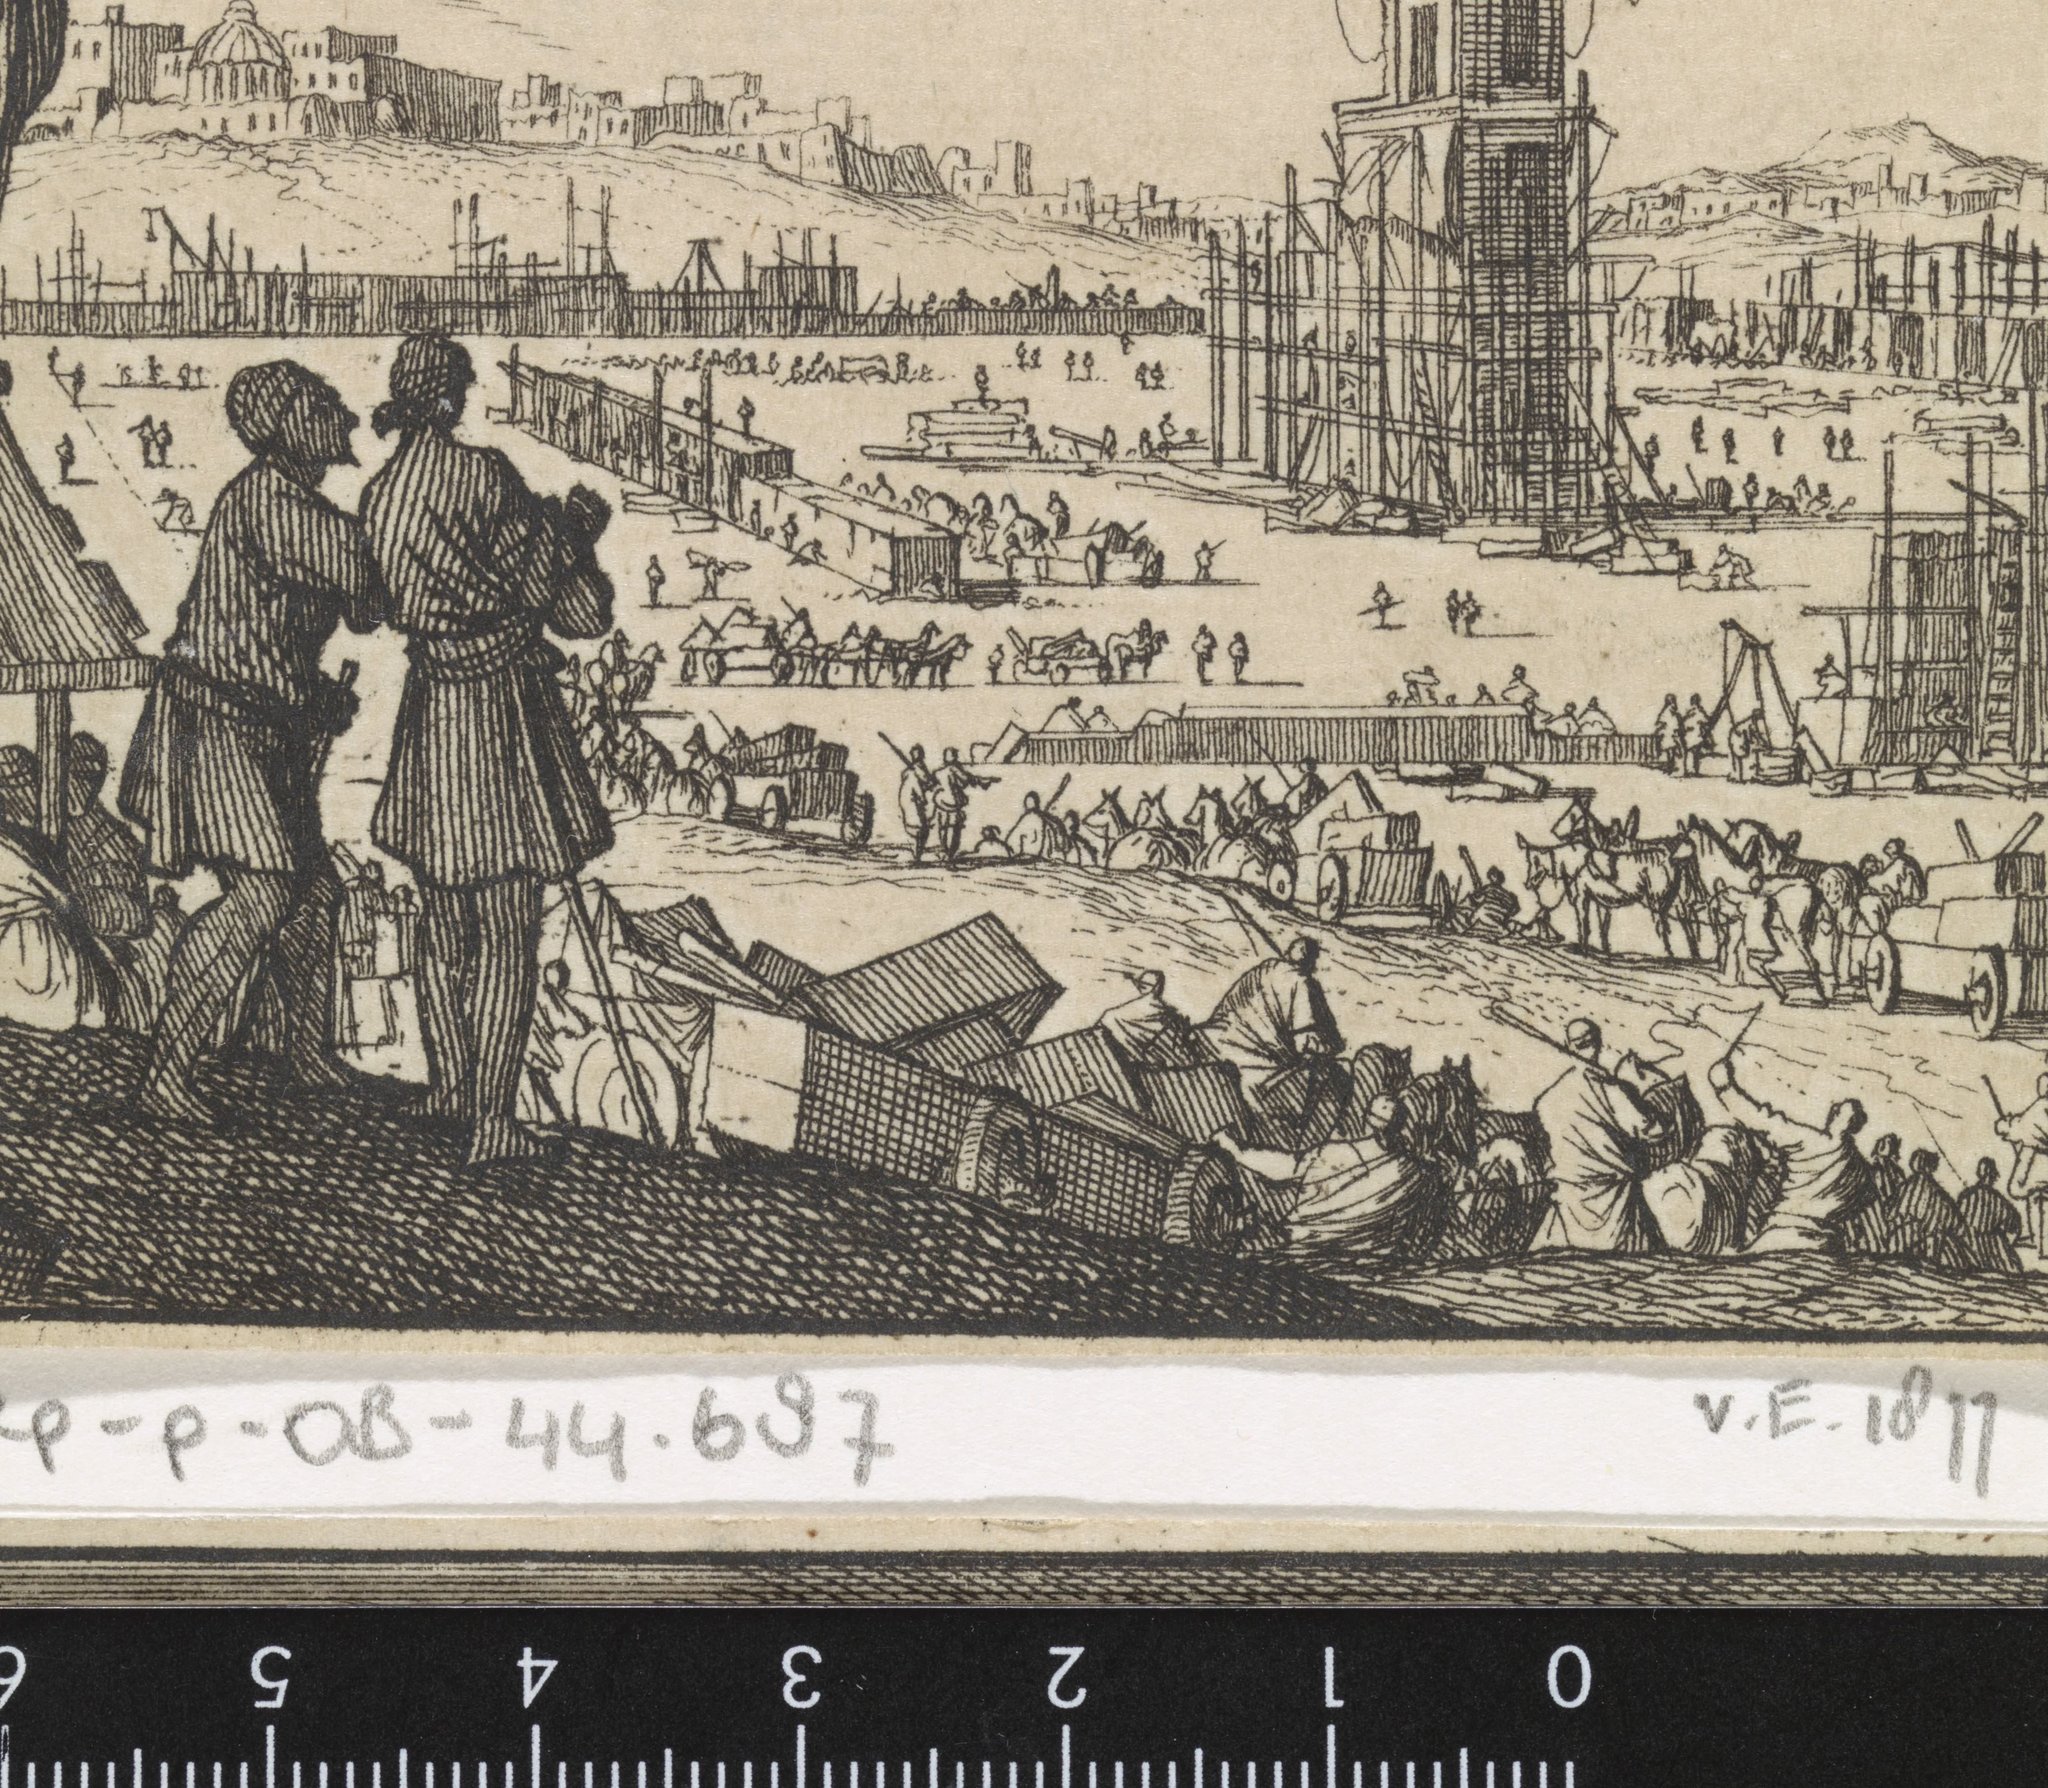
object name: print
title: Salomo bouwt de tempel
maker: caspar luyken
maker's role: draughtsman, print maker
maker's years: 1672-1708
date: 1698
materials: paper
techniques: etching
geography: amsterdam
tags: the building of the temple of solomon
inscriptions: collector's mark: Lugt 2228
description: Proefdruk van illustratie uit: Josephus, Flavius. XX. boeken van de oude geschiedenissen der joden, 4 delen. Amsterdam: Barent Visscher, Willem de Coup, Willem van Lamsveld, Andries van Damme, 1698, dl. I.